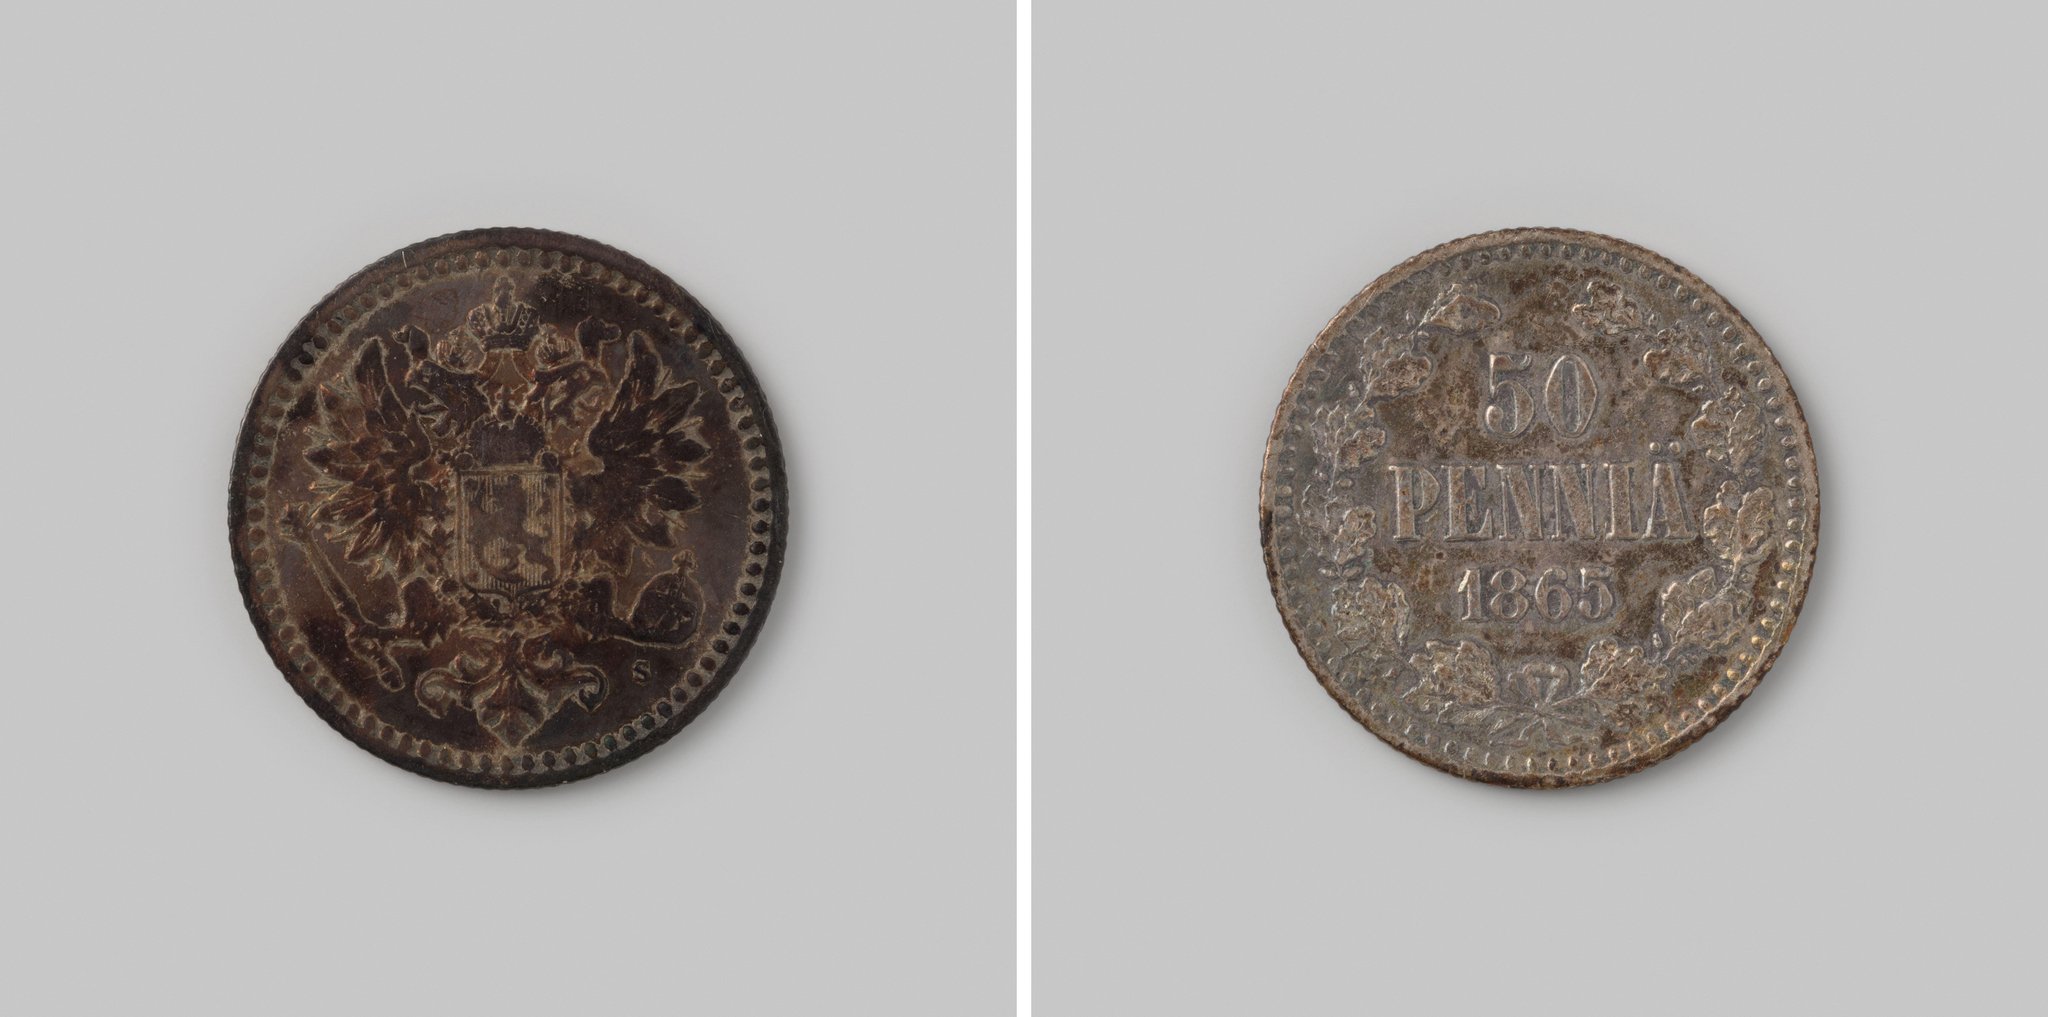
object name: coin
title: Finland, tsaar Alexander II, 50 penniä, 1865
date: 1865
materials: silver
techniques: striking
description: Zilveren munt. Voorzijde: dubbelkoppige gekroonde adelaar met gespreide vleugels en met op zijn borst een met een ridderorde omhangen wapenschild van Finland en in zijn poten een scepter en een gekroonde bol. Boven de adelaar een kroon met lint. Keerzijde: tussen twee samengebonden takken in twee regels waarde-aanduiding, waaronder jaartal. Kartelrand.